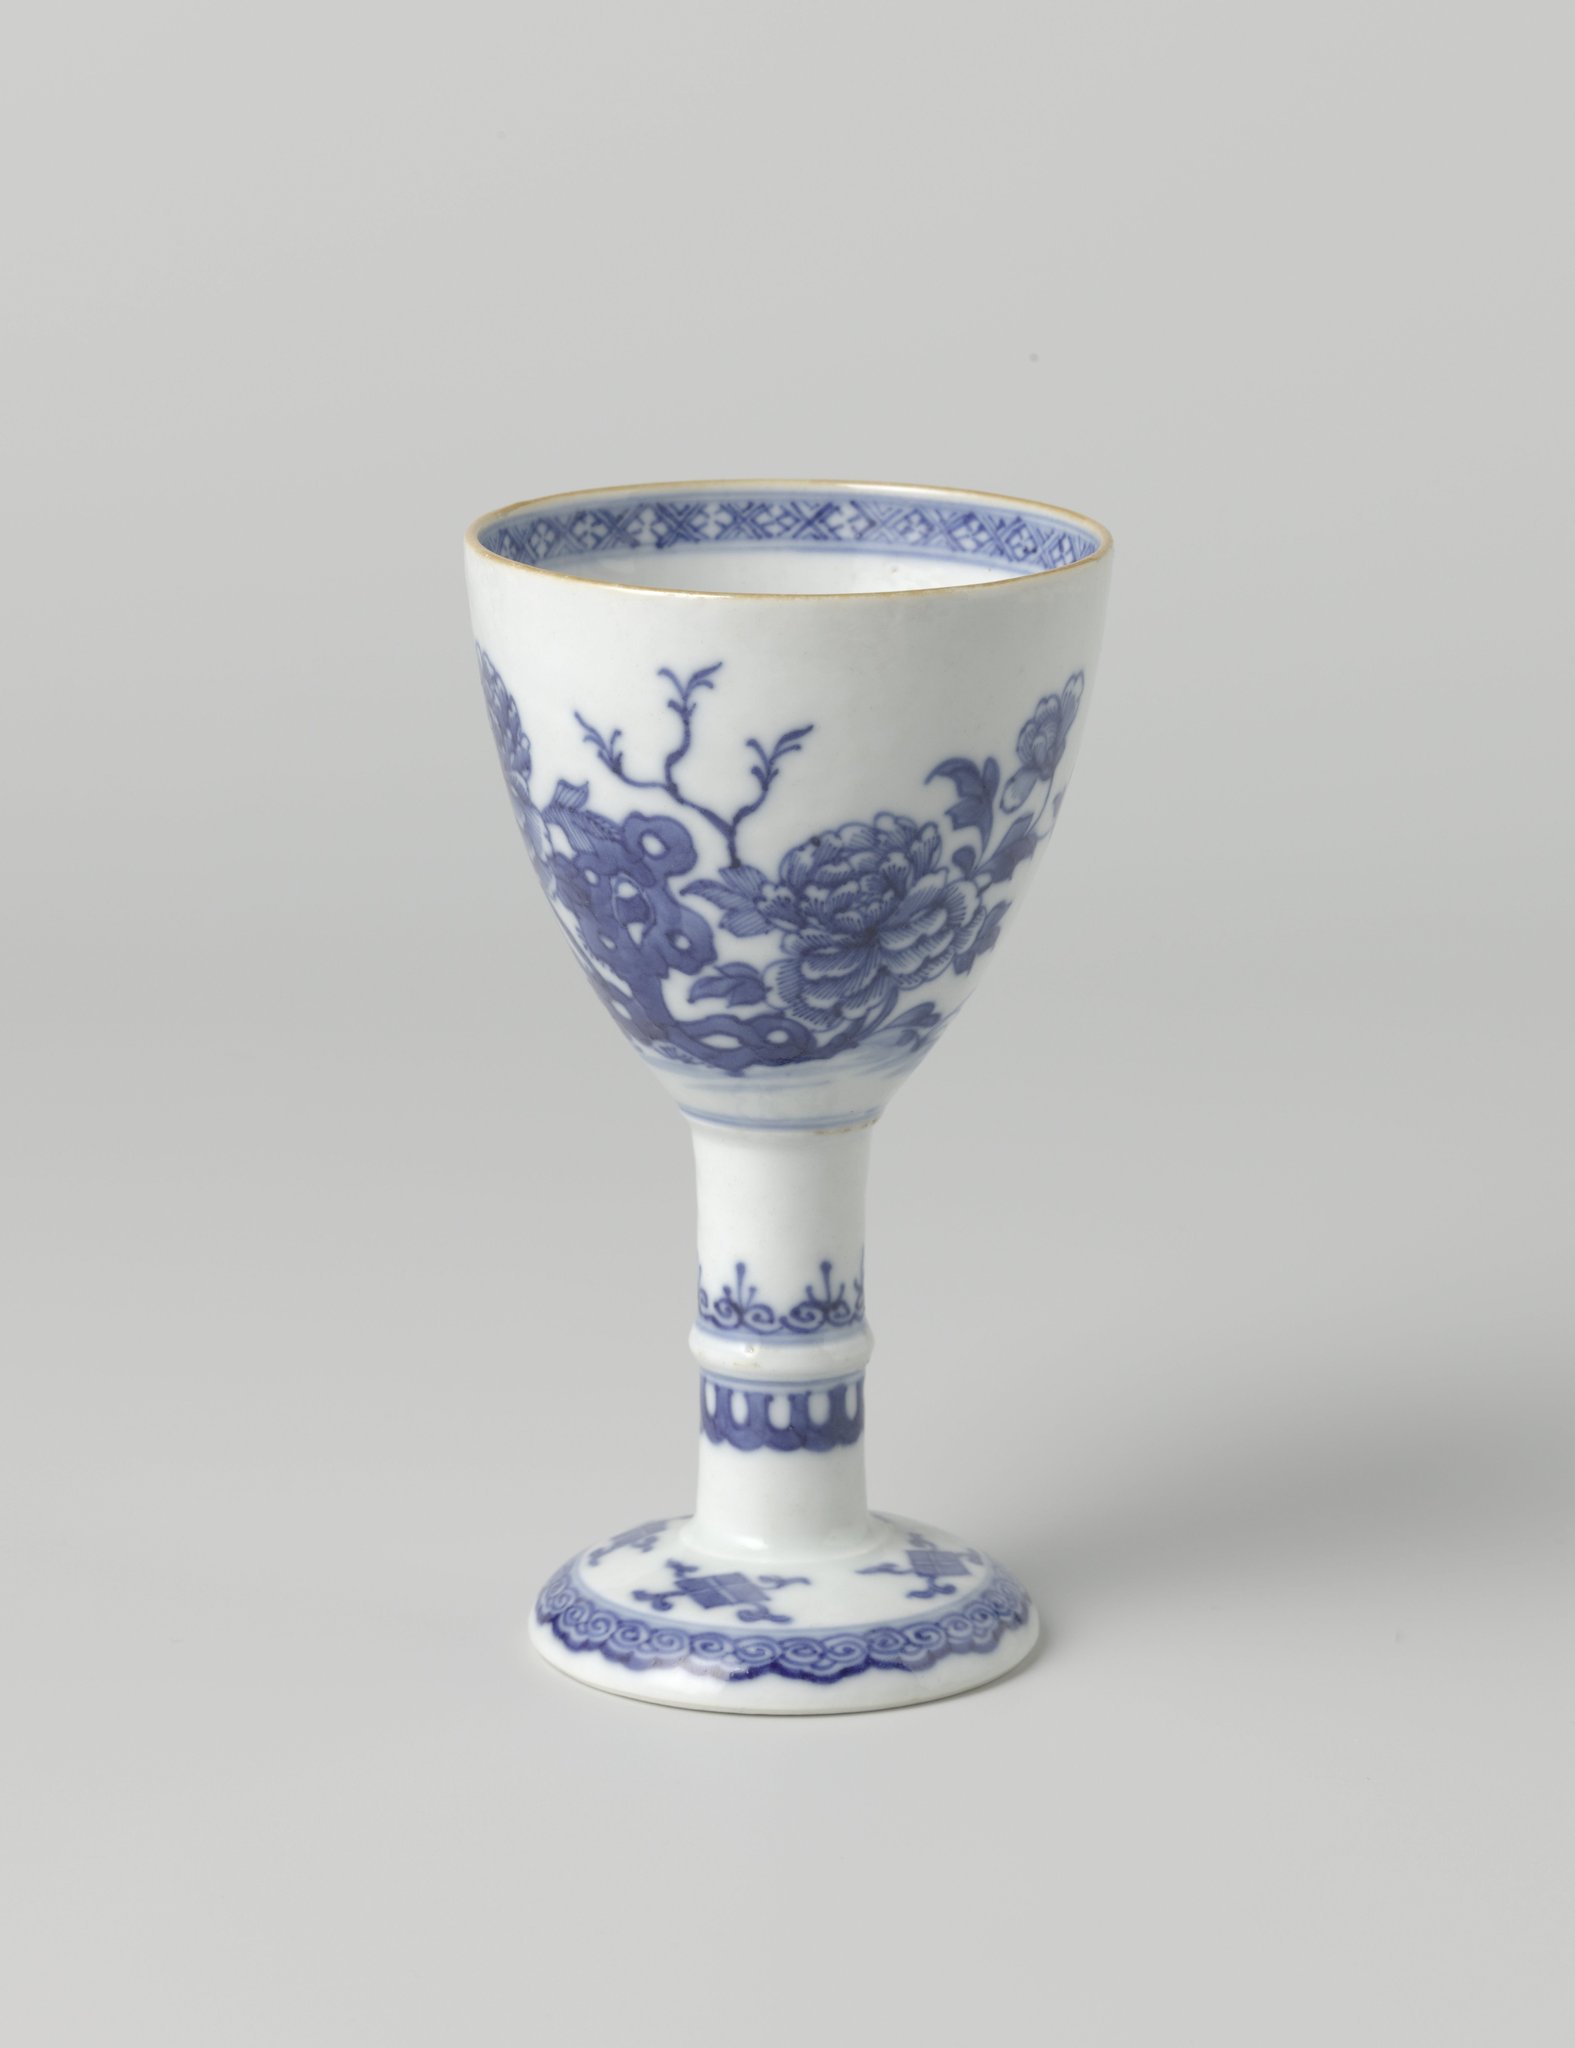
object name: cup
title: Stemcup with rocks, peony sprays and butterfly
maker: Anonymous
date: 1700-1724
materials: cobalt, glaze, paint, porcelain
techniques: firing, turning, vitrification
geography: china